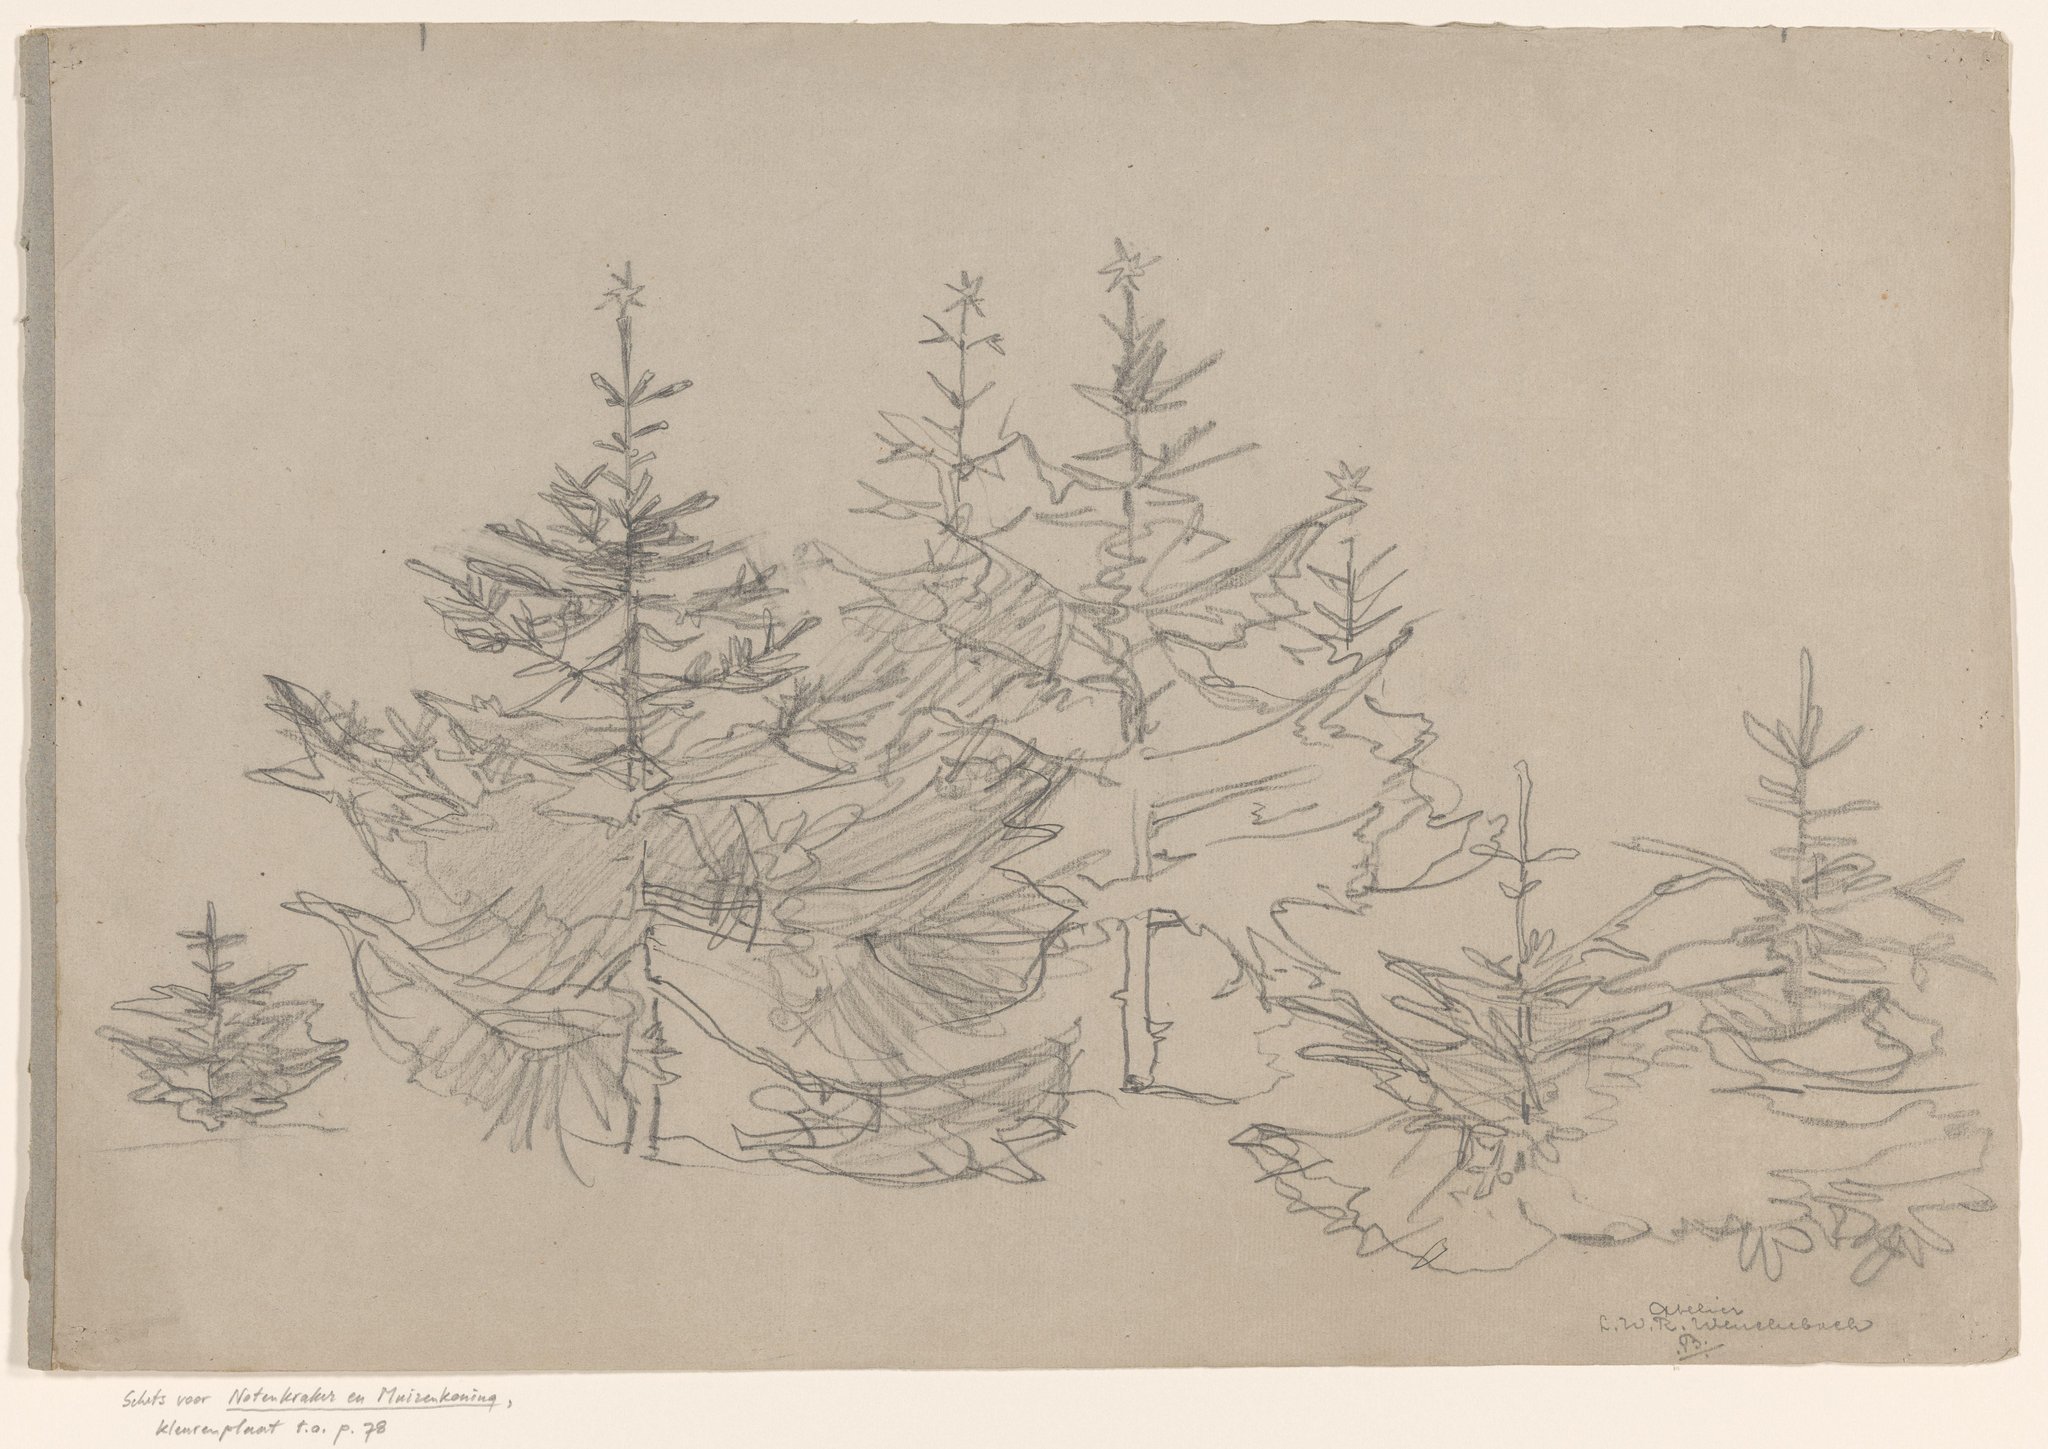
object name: boekillustratie ontwerp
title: Kerstbomenbos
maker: willem wenckebach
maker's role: designer, draughtsman, painter, print maker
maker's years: 1860-1937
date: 1898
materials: paper, pencil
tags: christmas tree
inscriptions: collector's mark: Lugt 2228a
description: Ontwerp voor: Hoffman, Ernst Theodor Amadeus. Notenkraker en muizenkoning. Amsterdam: Scheltema & Holkema, 1898.